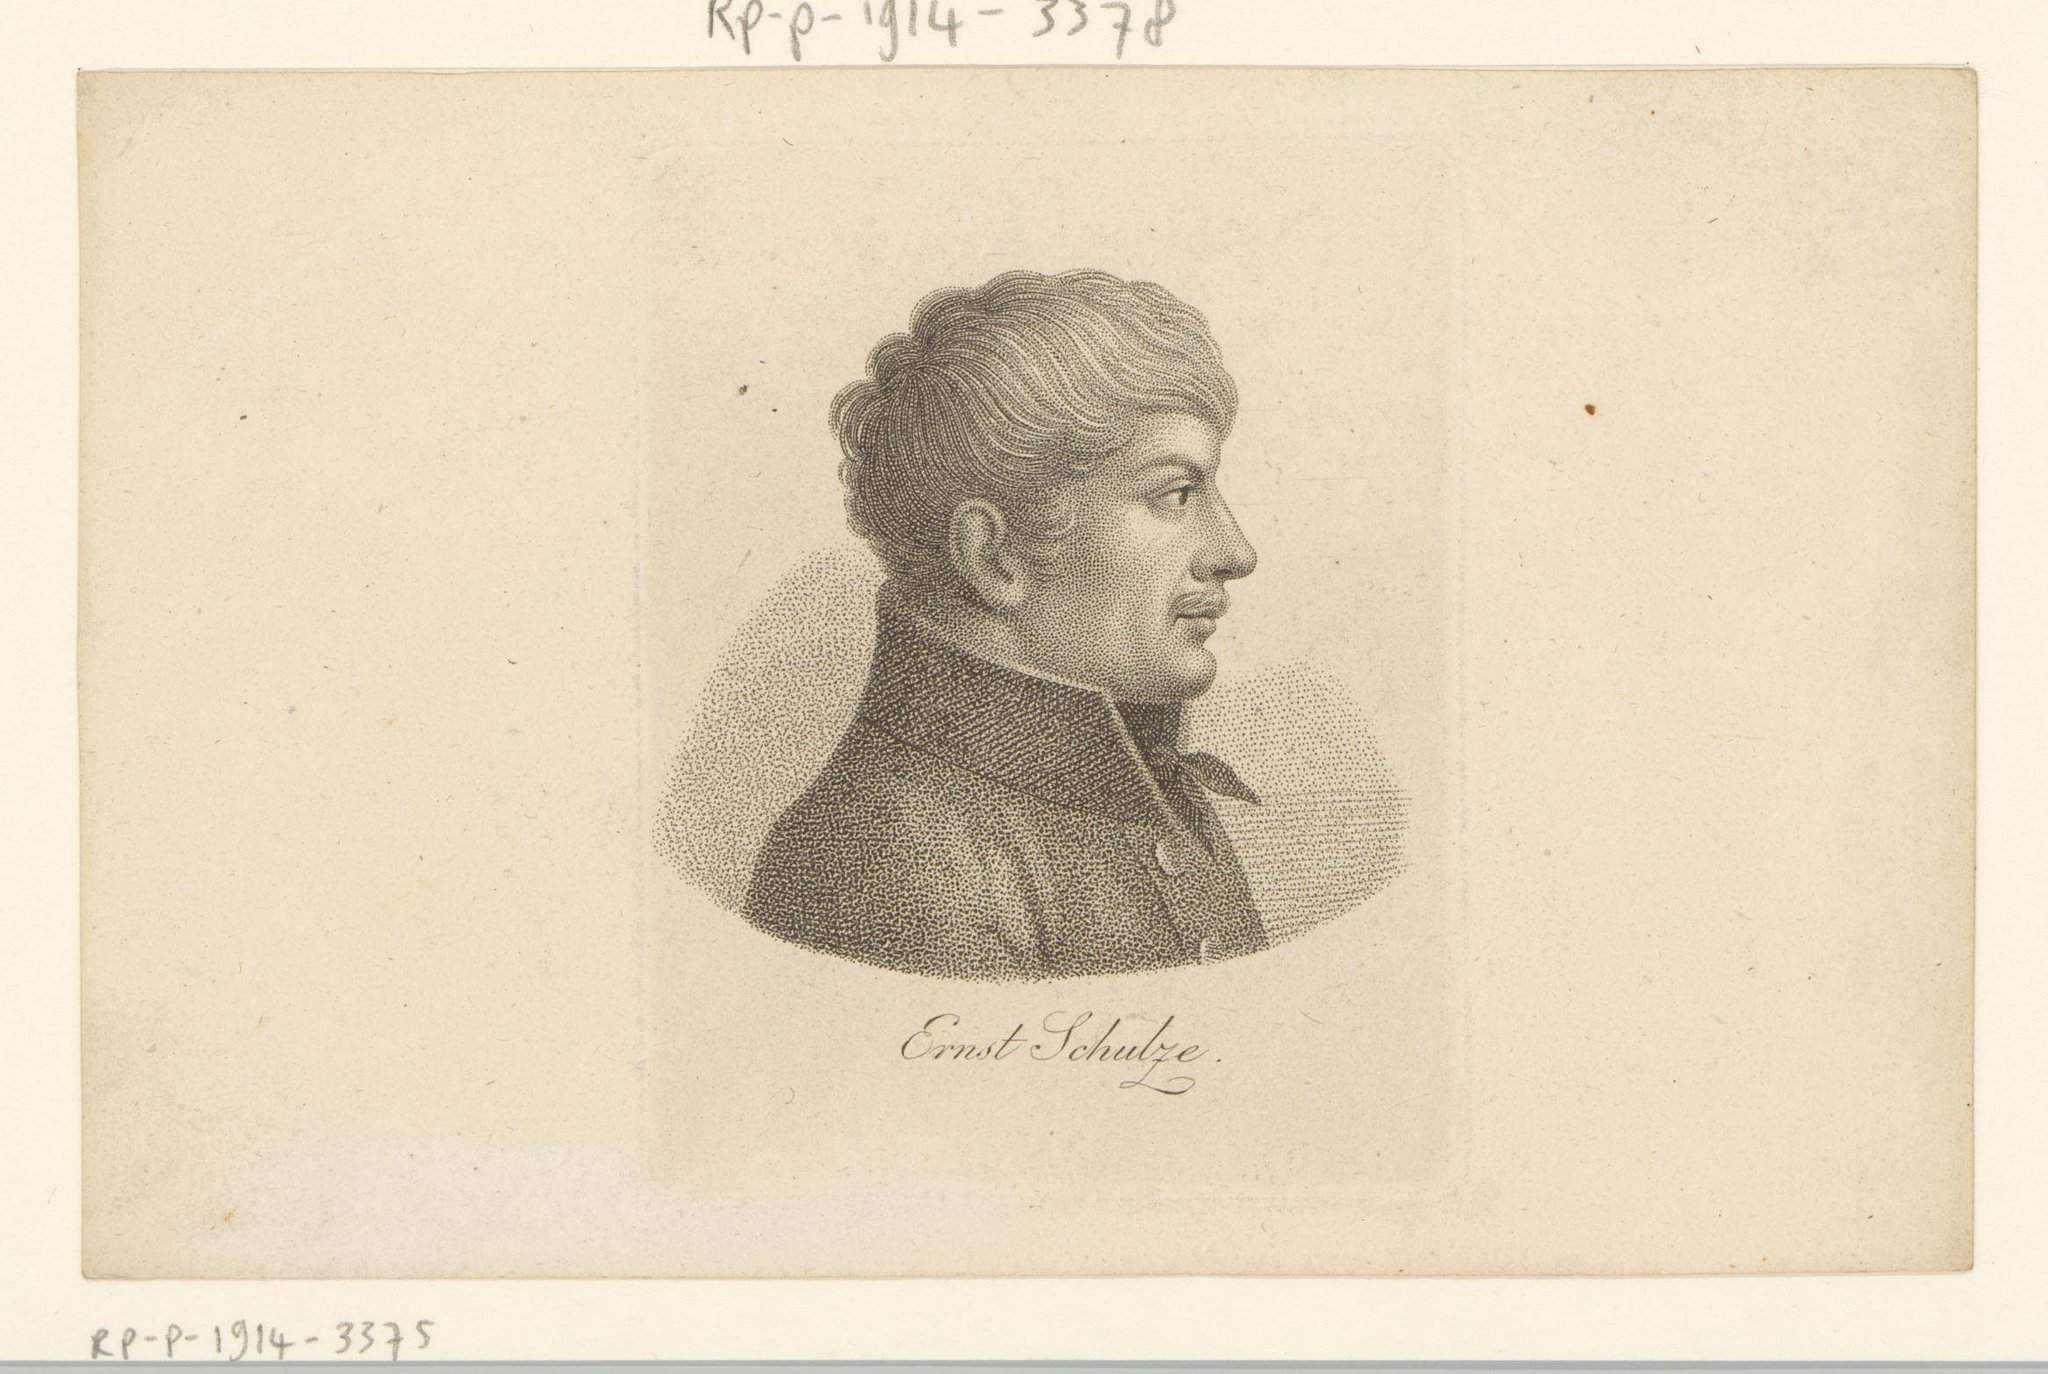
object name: print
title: Portret van Ernst Schulze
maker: ernst ludwig riepenhausen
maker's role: print maker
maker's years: 1765-1840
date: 1775-1840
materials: paper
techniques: engraving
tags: historical persons, portrait, self-portrait of painter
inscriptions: collector's mark: Lugt 2228